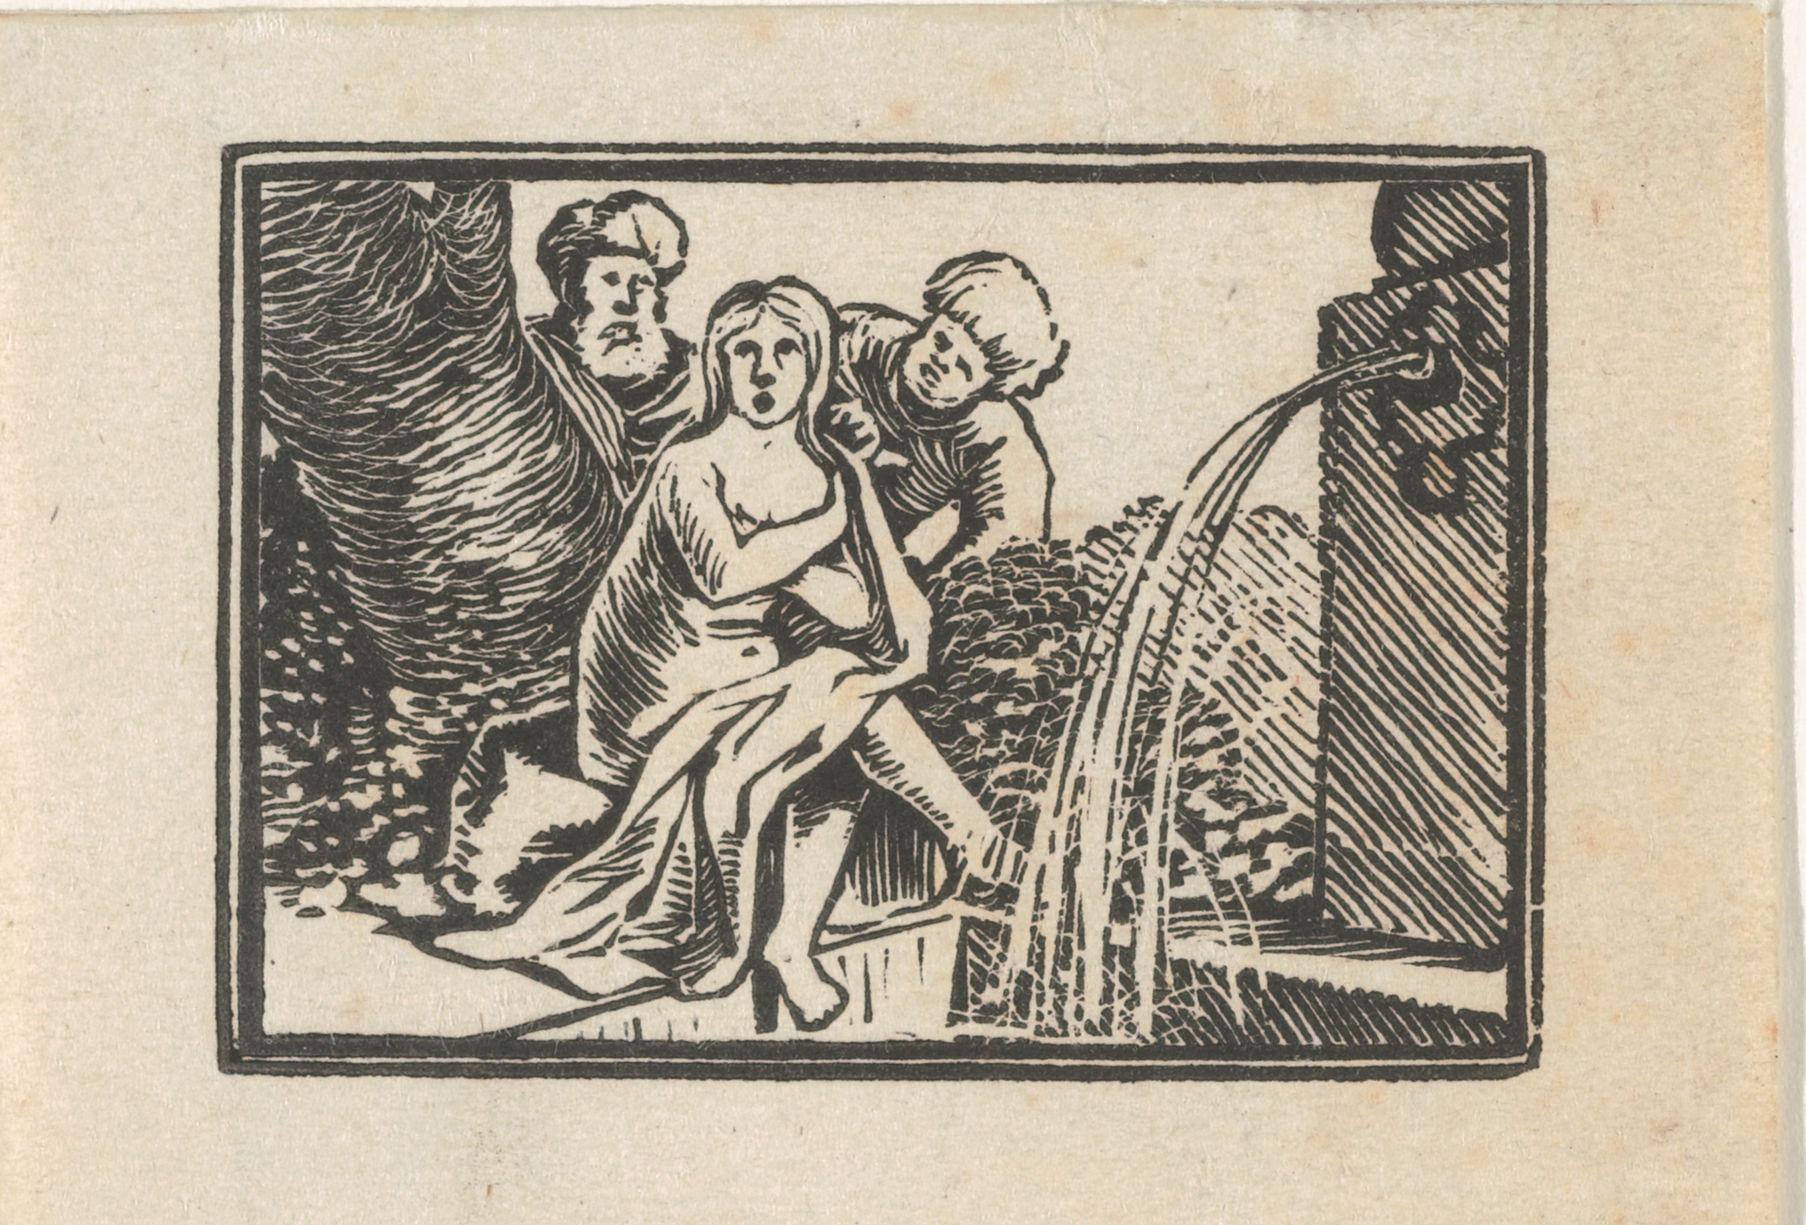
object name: print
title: Susanna en de ouderlingen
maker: dirck de bray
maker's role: draughtsman, painter, print maker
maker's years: 1625-1694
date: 1635-1694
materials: paper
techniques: woodcut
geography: netherlands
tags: the elders making advances towards susanna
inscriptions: collector's mark: Lugt 240